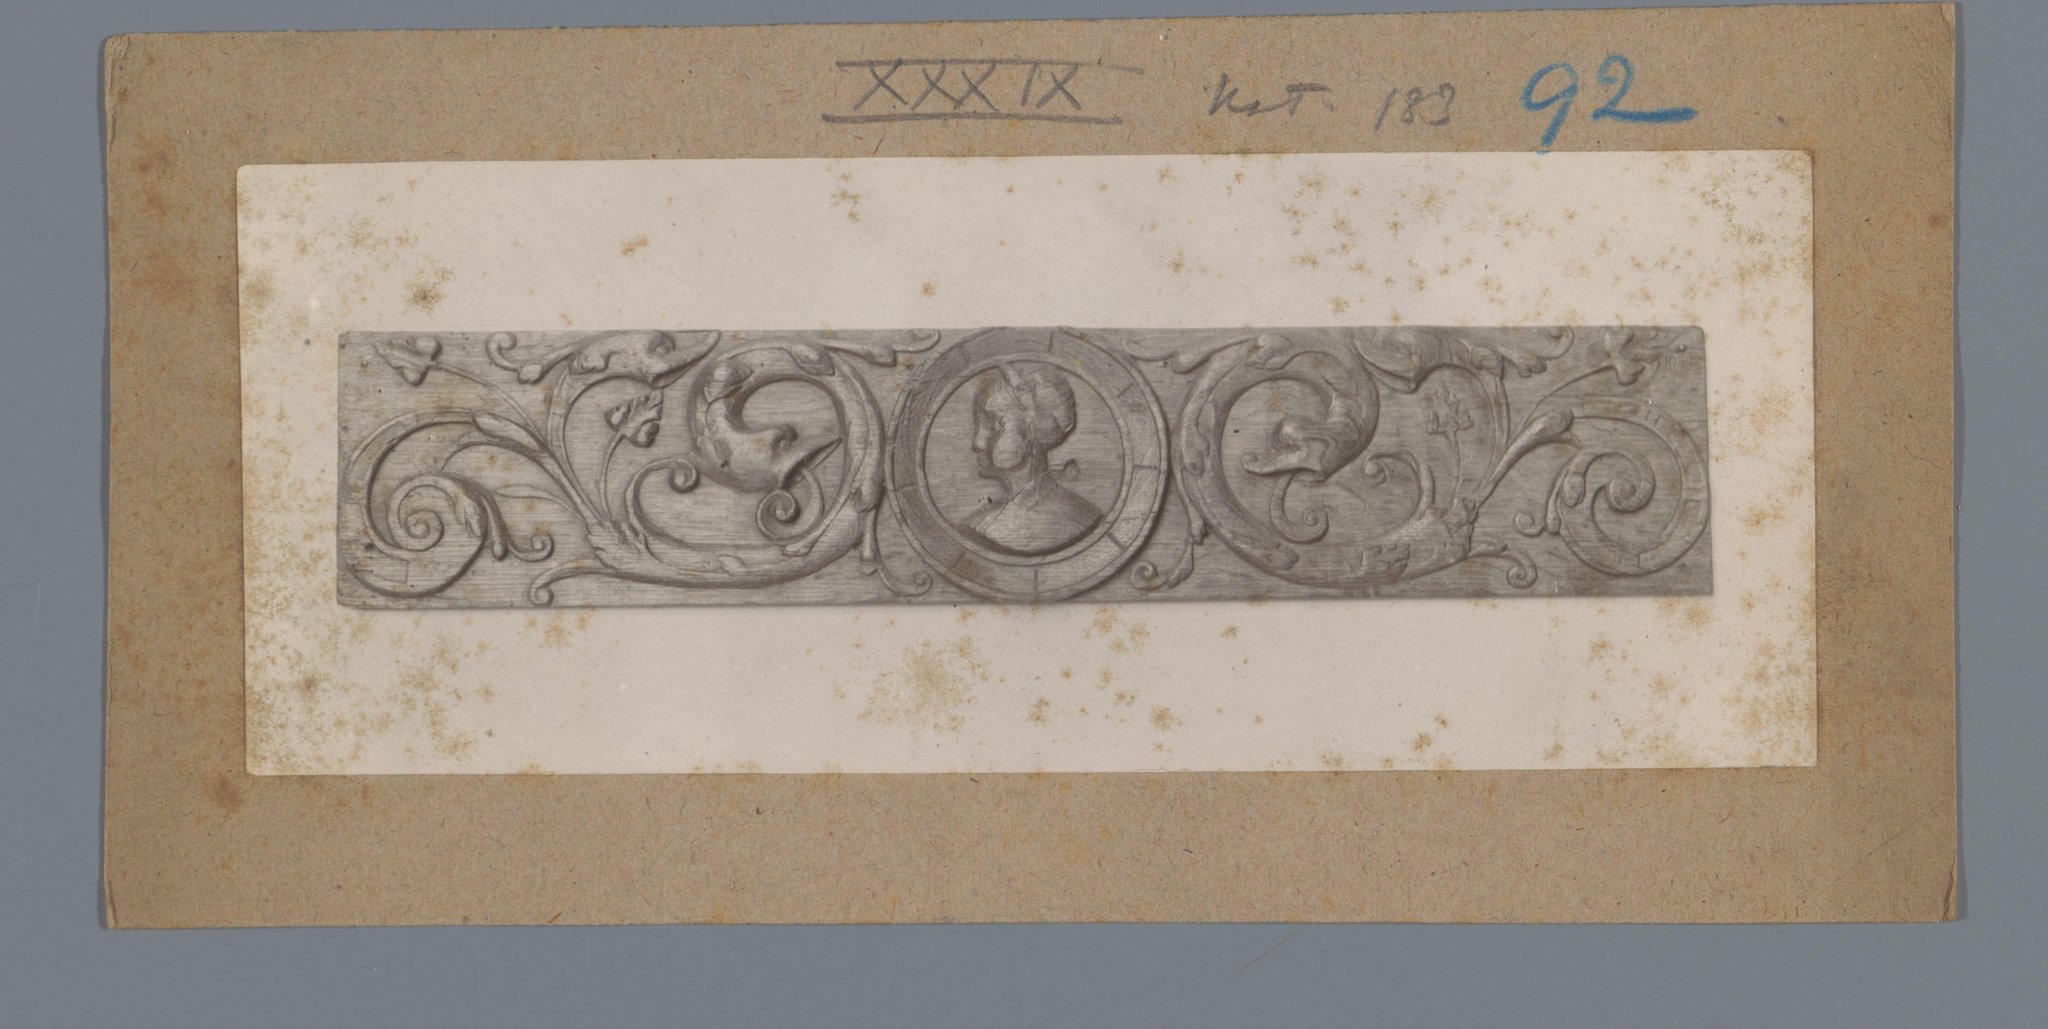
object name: photograph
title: Houten paneel gedecoreerd met een portret, dolfijnen en bladmotieven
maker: Anonymous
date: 1875-1900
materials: photographic support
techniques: matte daylight collodion silver print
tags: dolphin ~ ornament - aa - stylized, ornament derived from plant forms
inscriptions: collector's mark: ‘Kunstnijverheidschool Quellinus Amsterdam Frans Halsstraat 14.’, collector's mark: ‘Instituut voor kunst-nijverheidsonderwijs Gabriël Metsustraat No. 16, Amsterdam’, number: ‘XXXIX kat. 183 92’